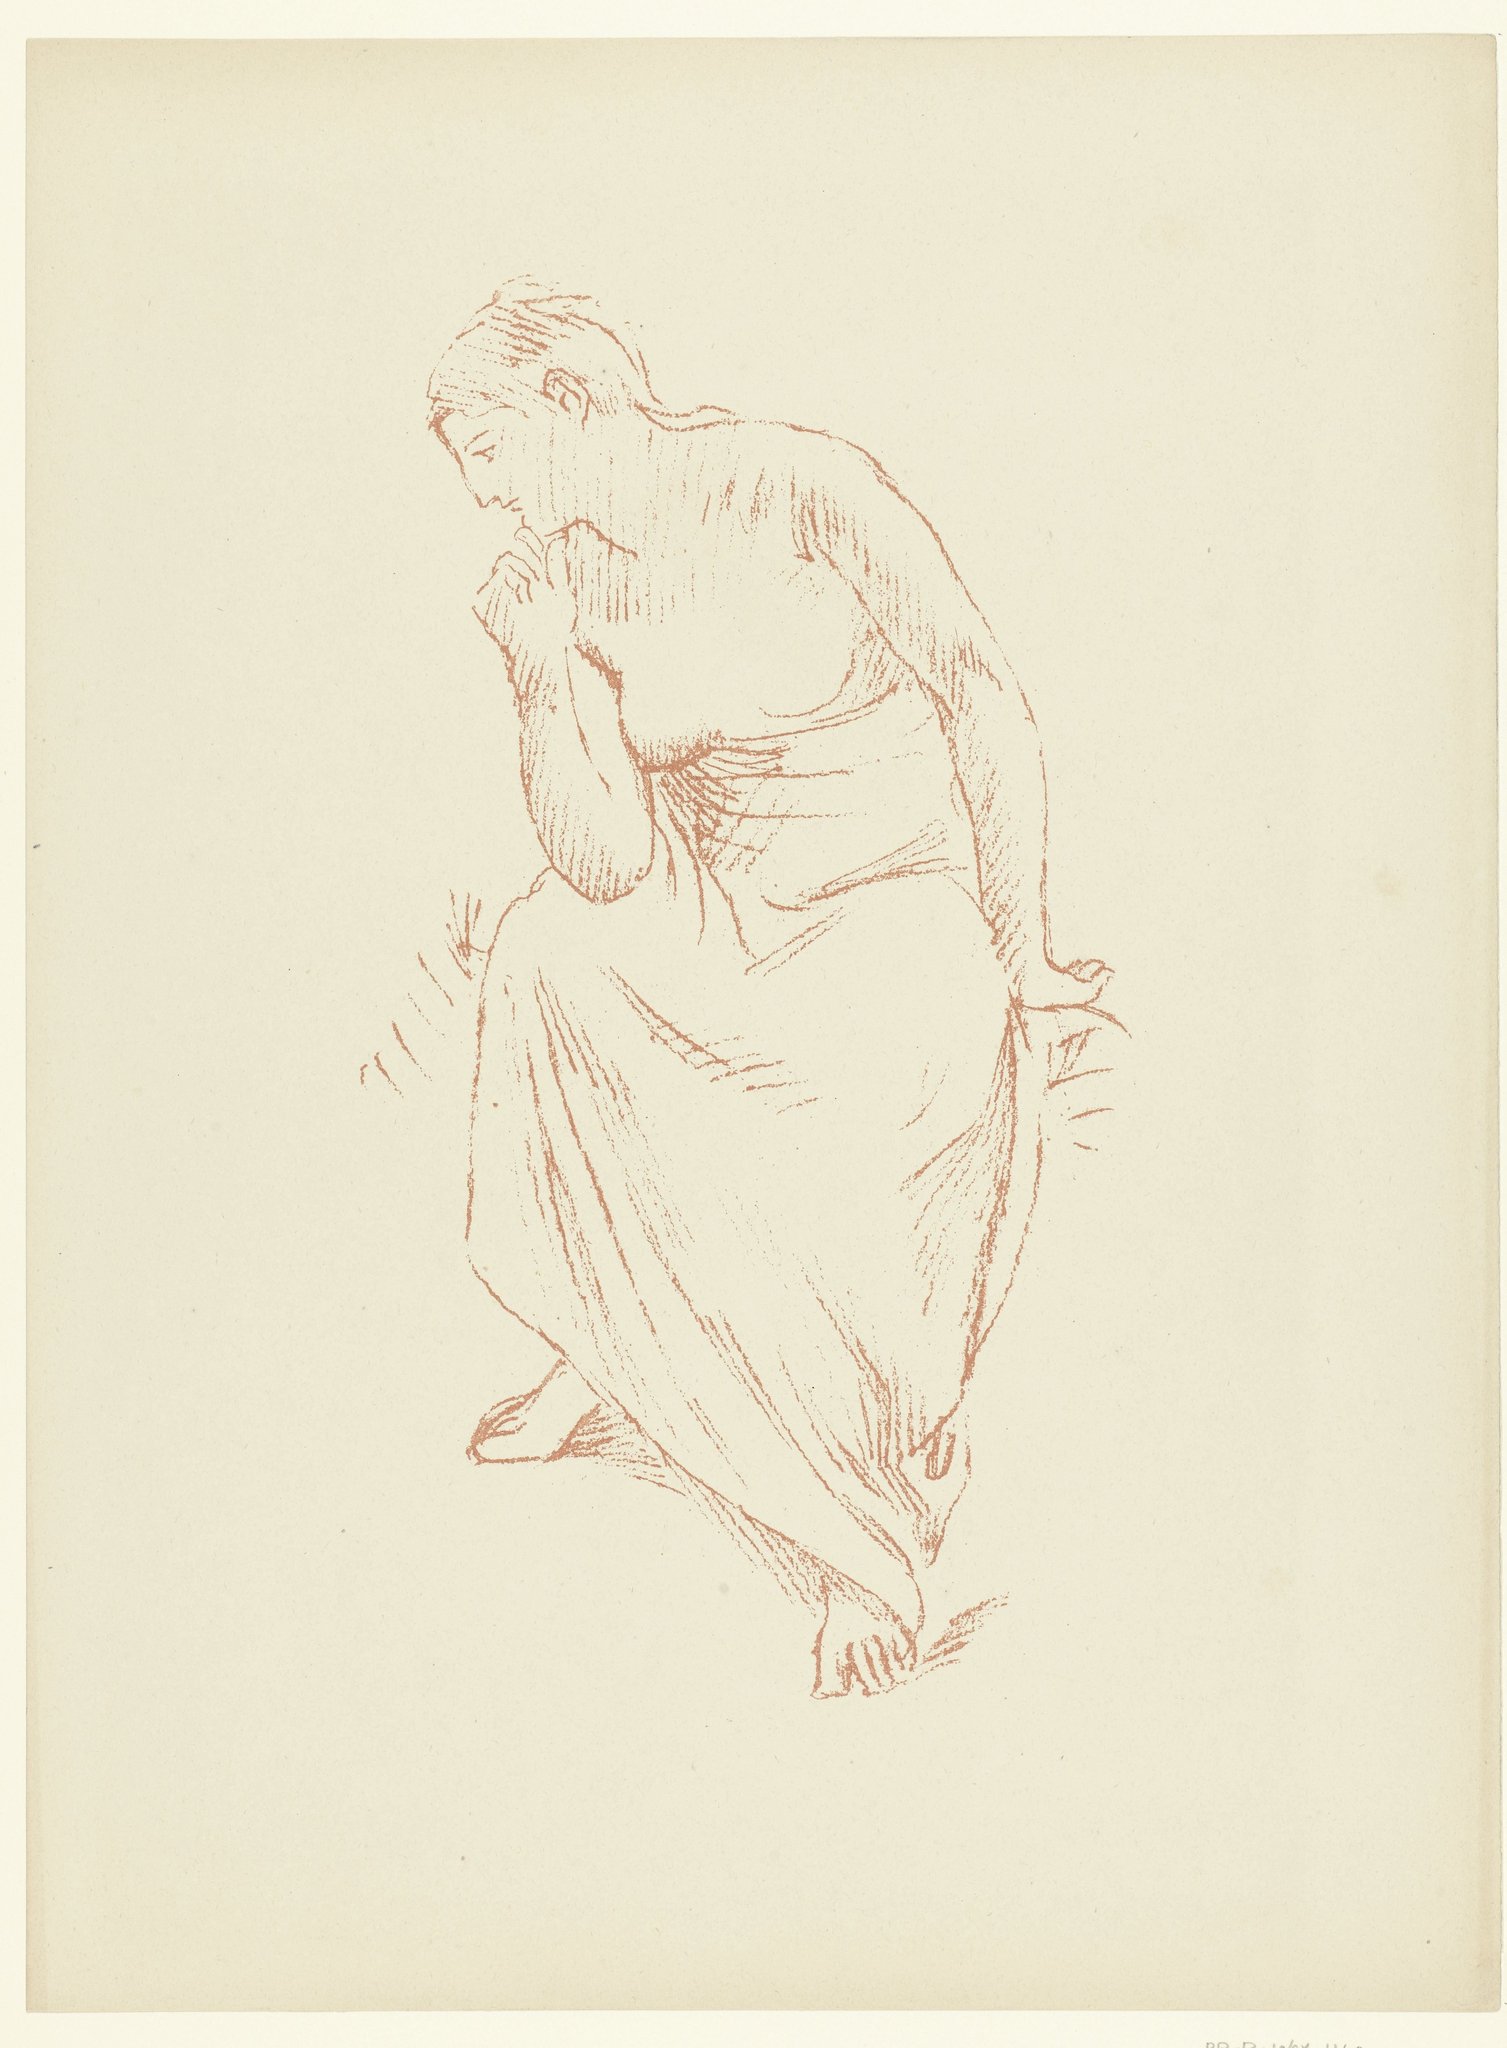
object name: print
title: Etude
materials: paper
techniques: printing, lithograph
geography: paris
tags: female sex; woman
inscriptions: collector's mark: Lugt 2228, collector's mark: Lugt 2760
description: Verschenen in album met tien originele prenten als supplement bij tijdschrift: L'Epreuve, editie nr. 12, 1895, prent nr. 2.